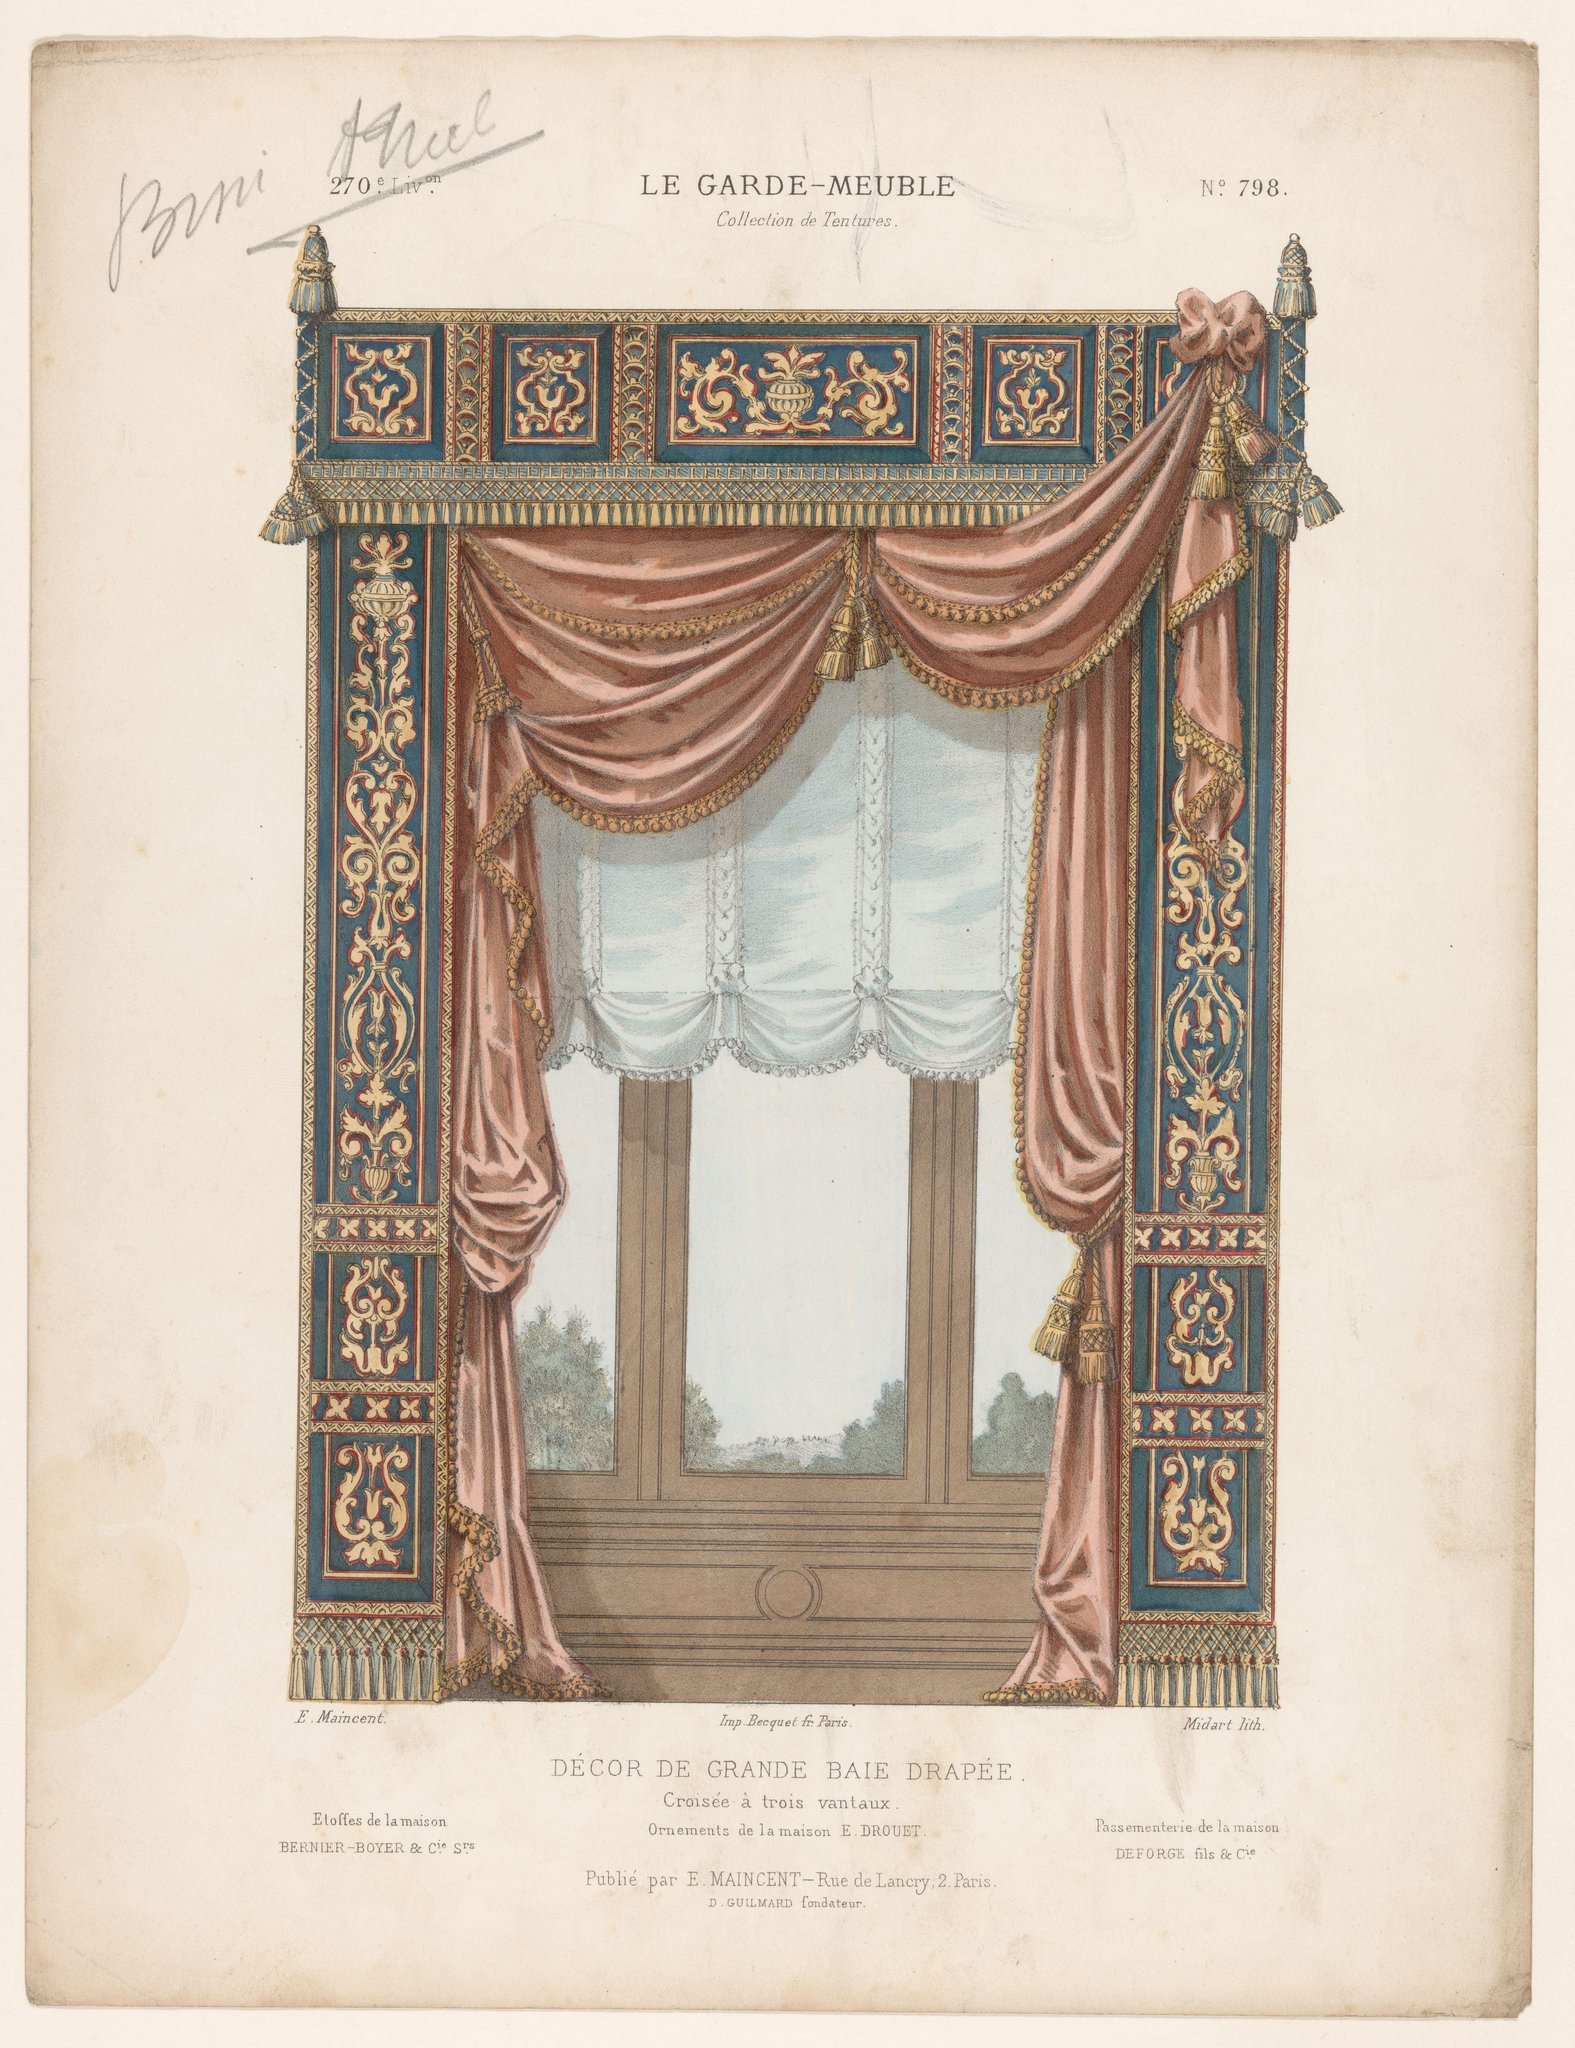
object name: print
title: Décor de Grande Baie drapée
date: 1885-1895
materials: paper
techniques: hand coloring, lithograph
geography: paris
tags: door, hangings and drapery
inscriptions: annotation: ‘[...]’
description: Grote doorgang met omlijsting en gedrapeerde gordijnen. Prent uit 270e Livraison.